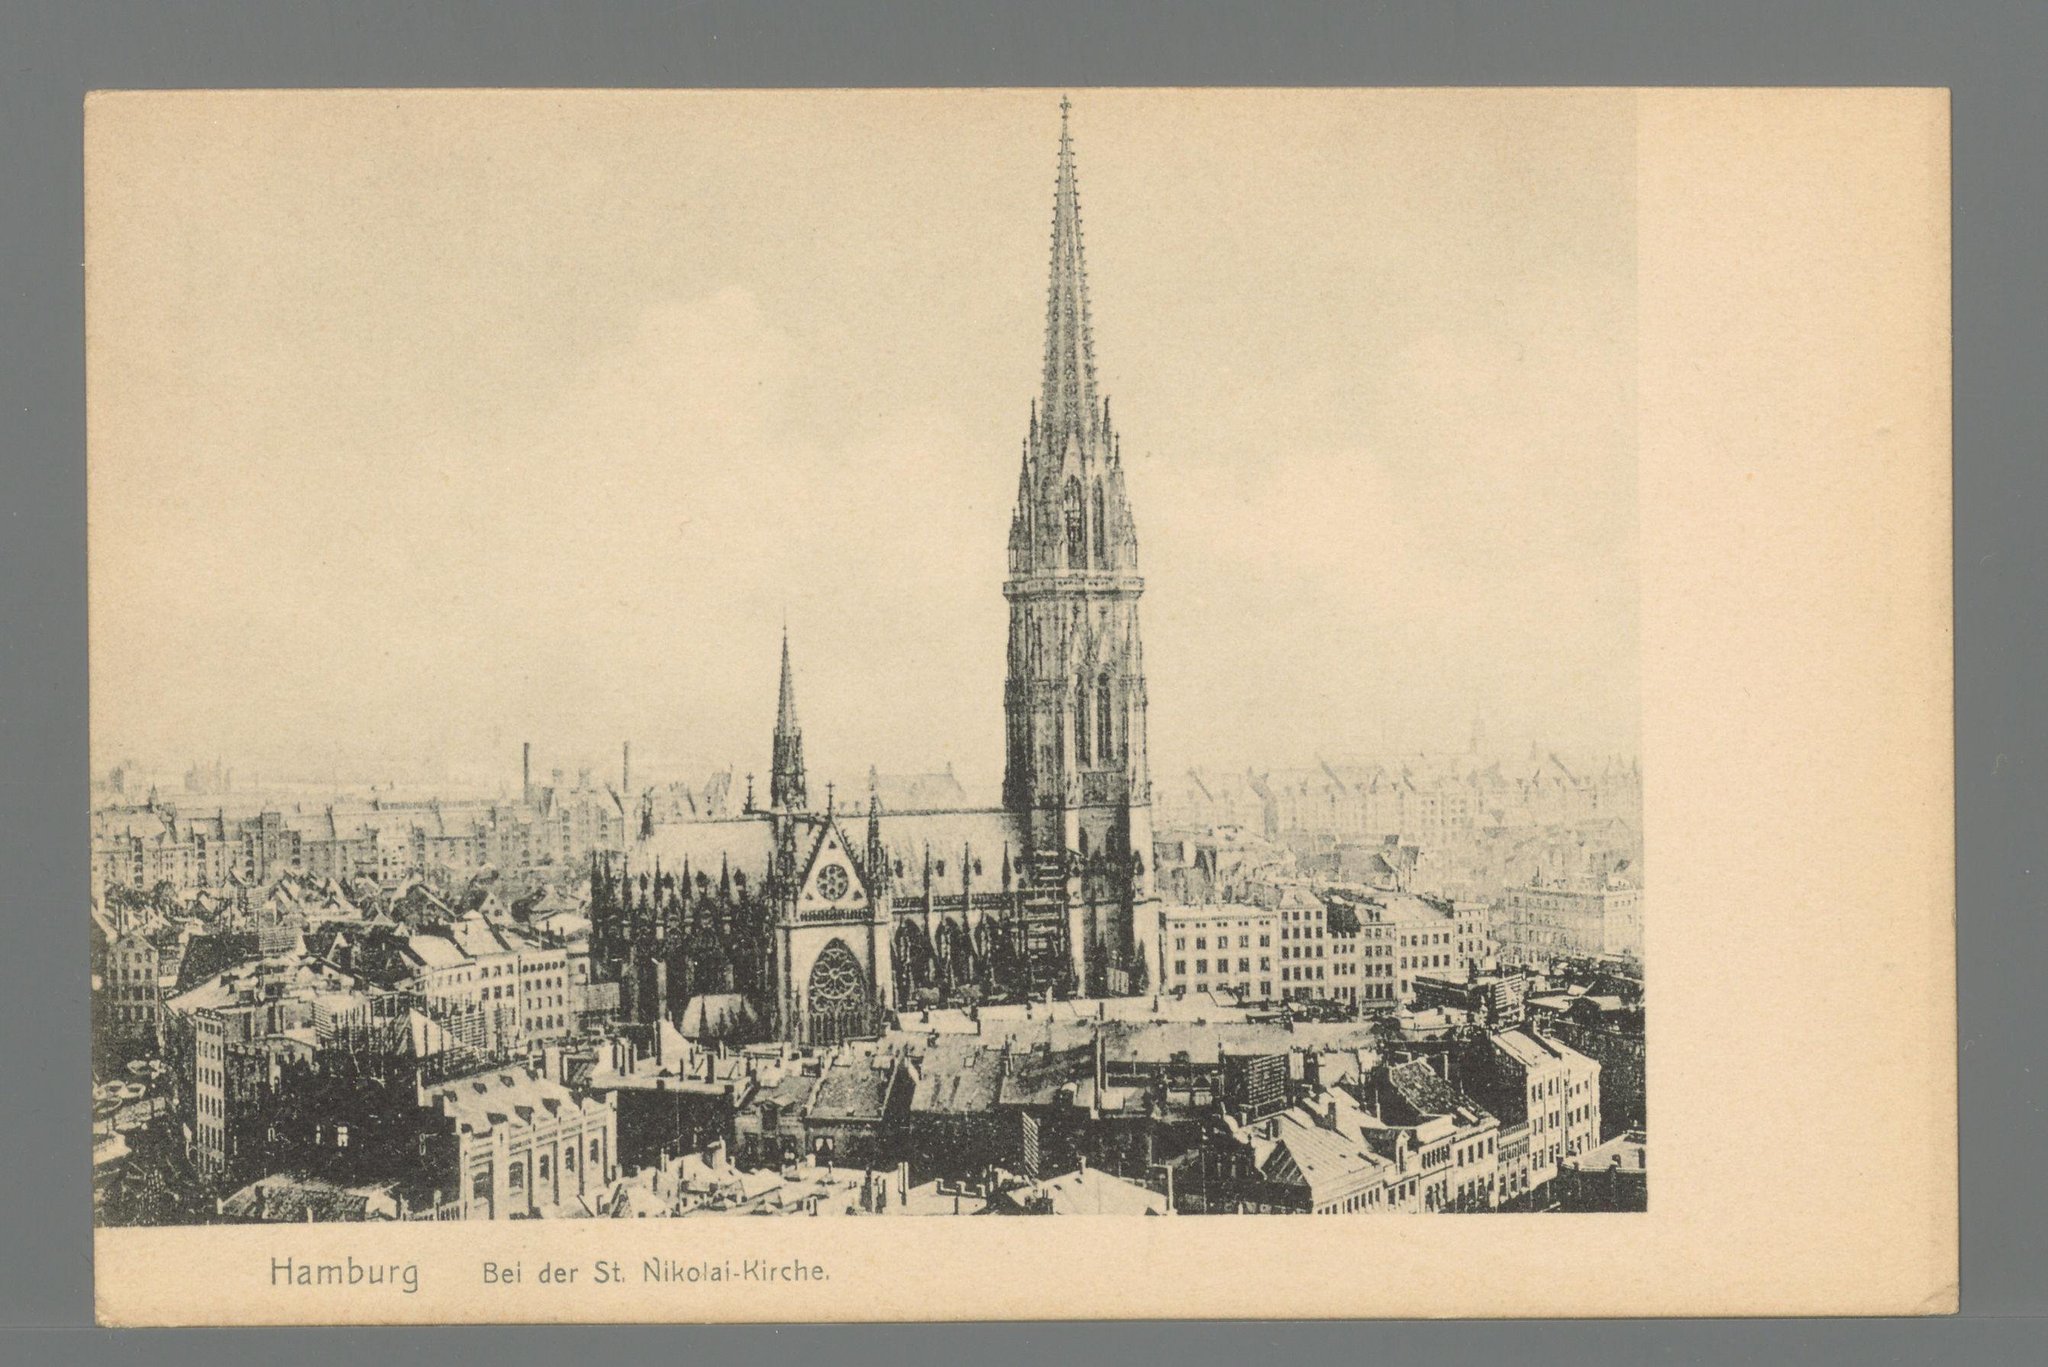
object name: ansichtkaart, prentbriefkaart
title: Hamburg. Bei der St. Nikolai-Kirche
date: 1905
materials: cardboard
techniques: photograph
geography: hamburg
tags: city-view, and landscape with man-made constructions, church (exterior)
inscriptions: date